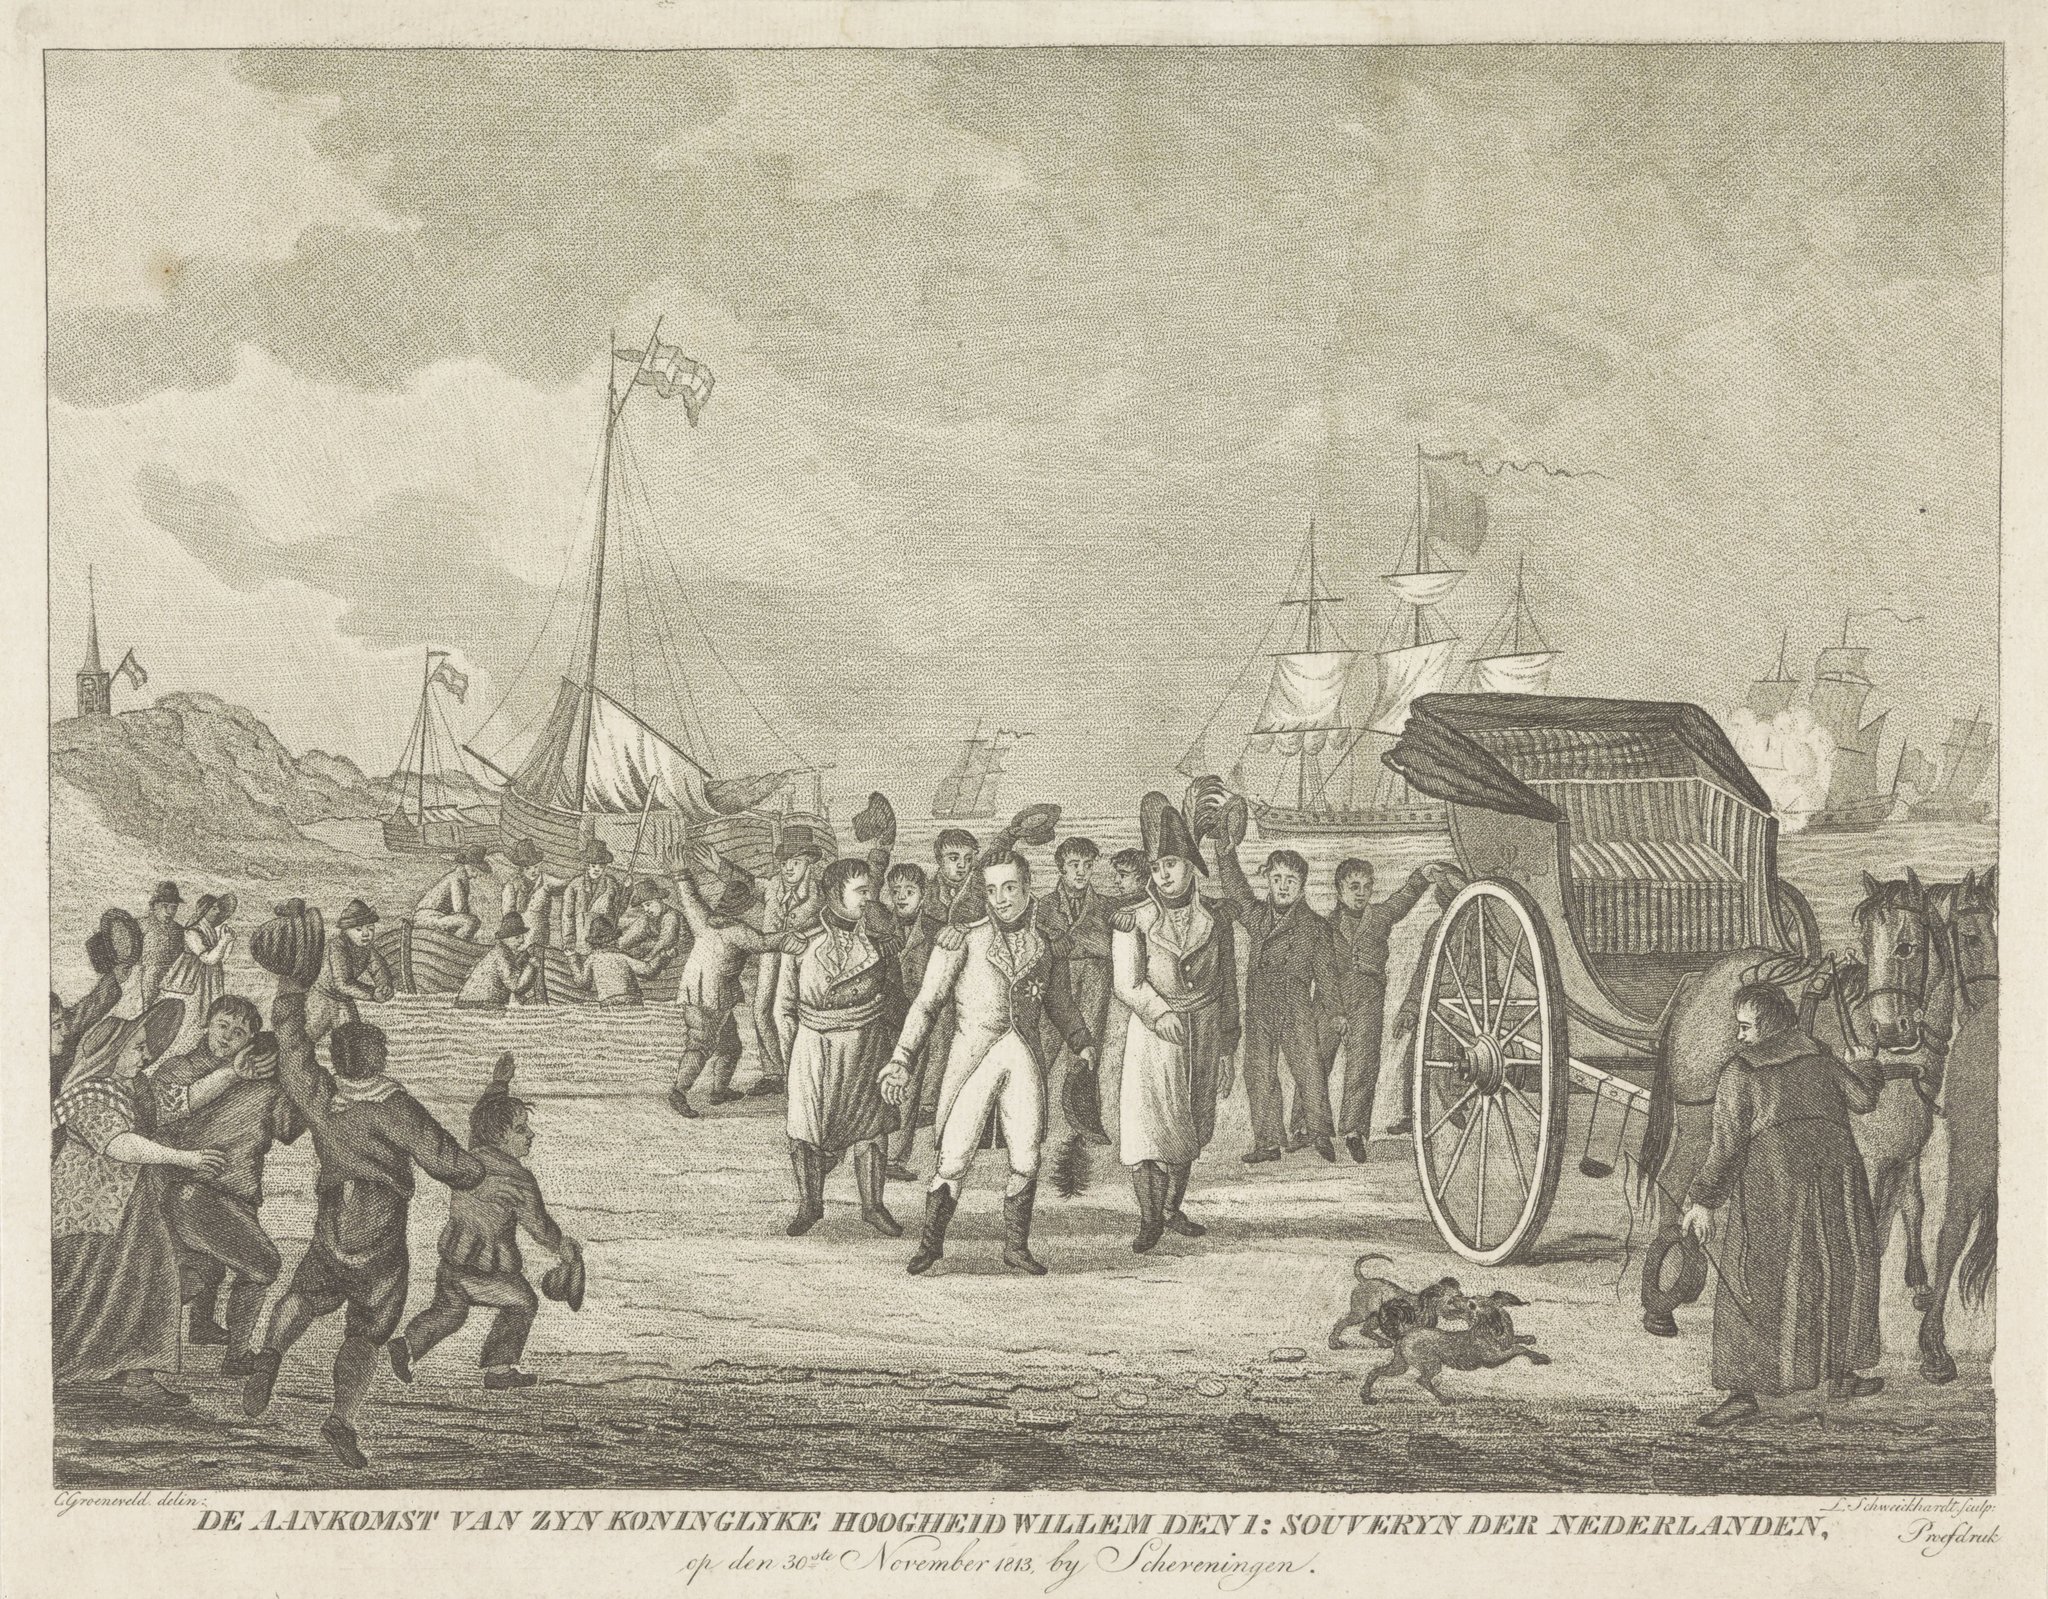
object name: print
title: Aankomst van de prins van Oranje te Scheveningen, 1813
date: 1813-1814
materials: paper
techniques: engraving, etching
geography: netherlands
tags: the hague, william i of the netherlands, being welcomed ~ travelling, homage to a ruler, landing of william frederick i (1813)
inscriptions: collector's mark: Lugt 2228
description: De aankomst van prins Willem Frederik als souverein vorst op het strand van Scheveningen op 30 november 1813. De prins loopt over het strand naar een gereedstaande rijtuig.